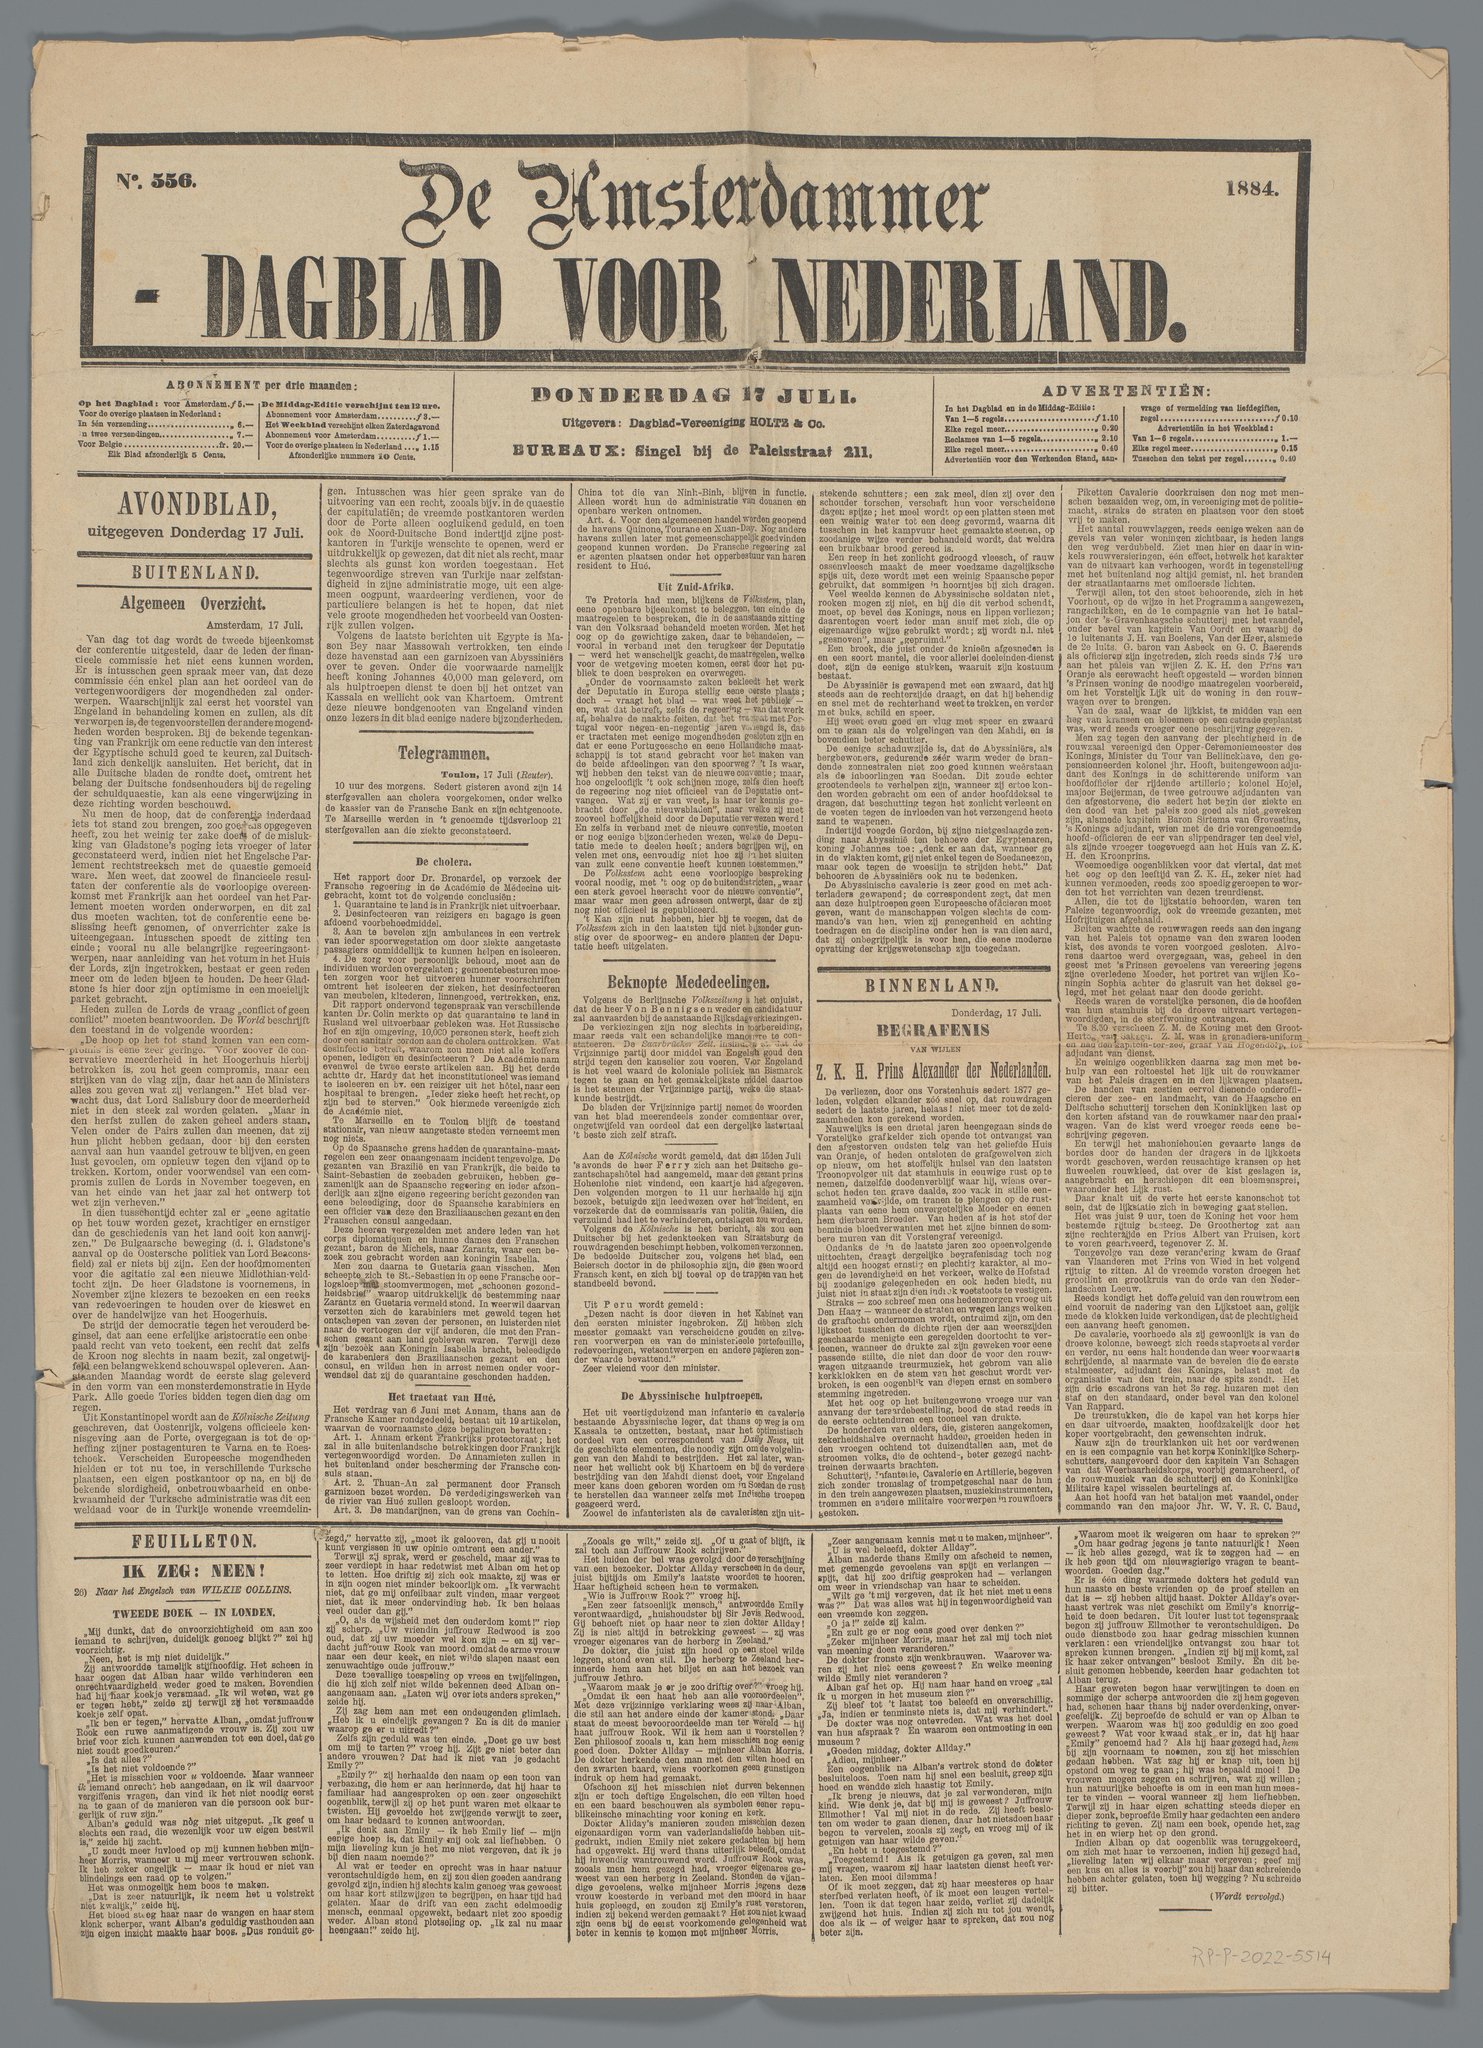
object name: newspaper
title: De Amsterdammer van 17 juli 1884 met een artikel over de begrafenis van prins Alexander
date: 1884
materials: paper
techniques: letterpress printing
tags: the hague, funerary ceremonial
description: Opgevouwen exemplaar van de krant De Amsterdammer / Dagblad voor Nederland, nr. 556, van 17 juli 1884 met een artikel over de begrafenis van prins Alexander op 17 juli.